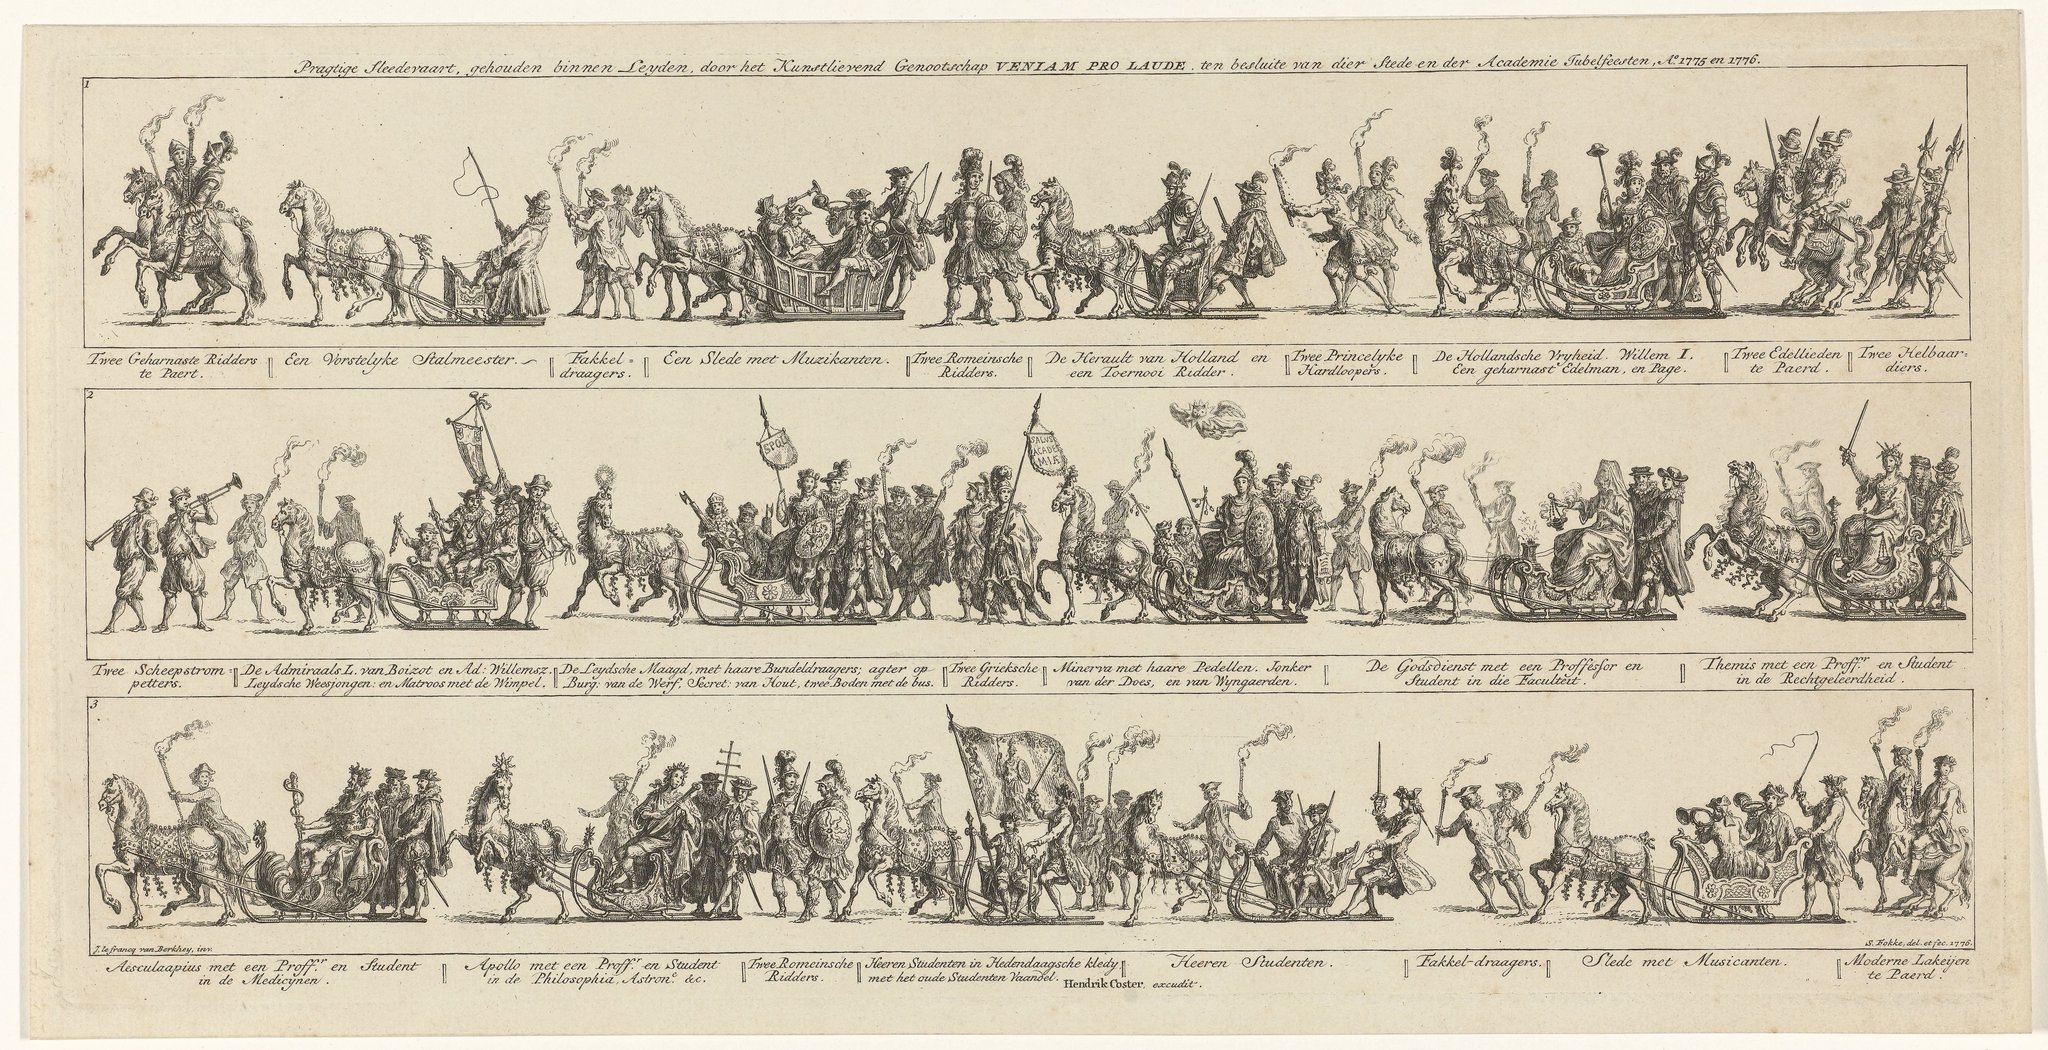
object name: print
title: Sledevaart door het Leidse genootschap Veniam Pro Laude, 1776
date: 1776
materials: paper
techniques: etching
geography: northern netherlands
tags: sledge, sleigh (winter sports), commemoration of the founding of a university, leiden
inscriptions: collector's mark: Lugt 2228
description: De sledevaart op 24 januari 1776 georganiseerd door het Leidse genootschap Veniam Pro Laude bij gelegenheid van het Tweede Eeuwfeest van het Leids Ontzet (3 oktober 1574) en de oprichting van de Universiteit van Leiden (8 februari 1575). De veertien sleden in drie rijen onder elkaar, genummerd 1-3, met aanduiding van het onderwerp van de slede. Staat met de uil bij Minerva.